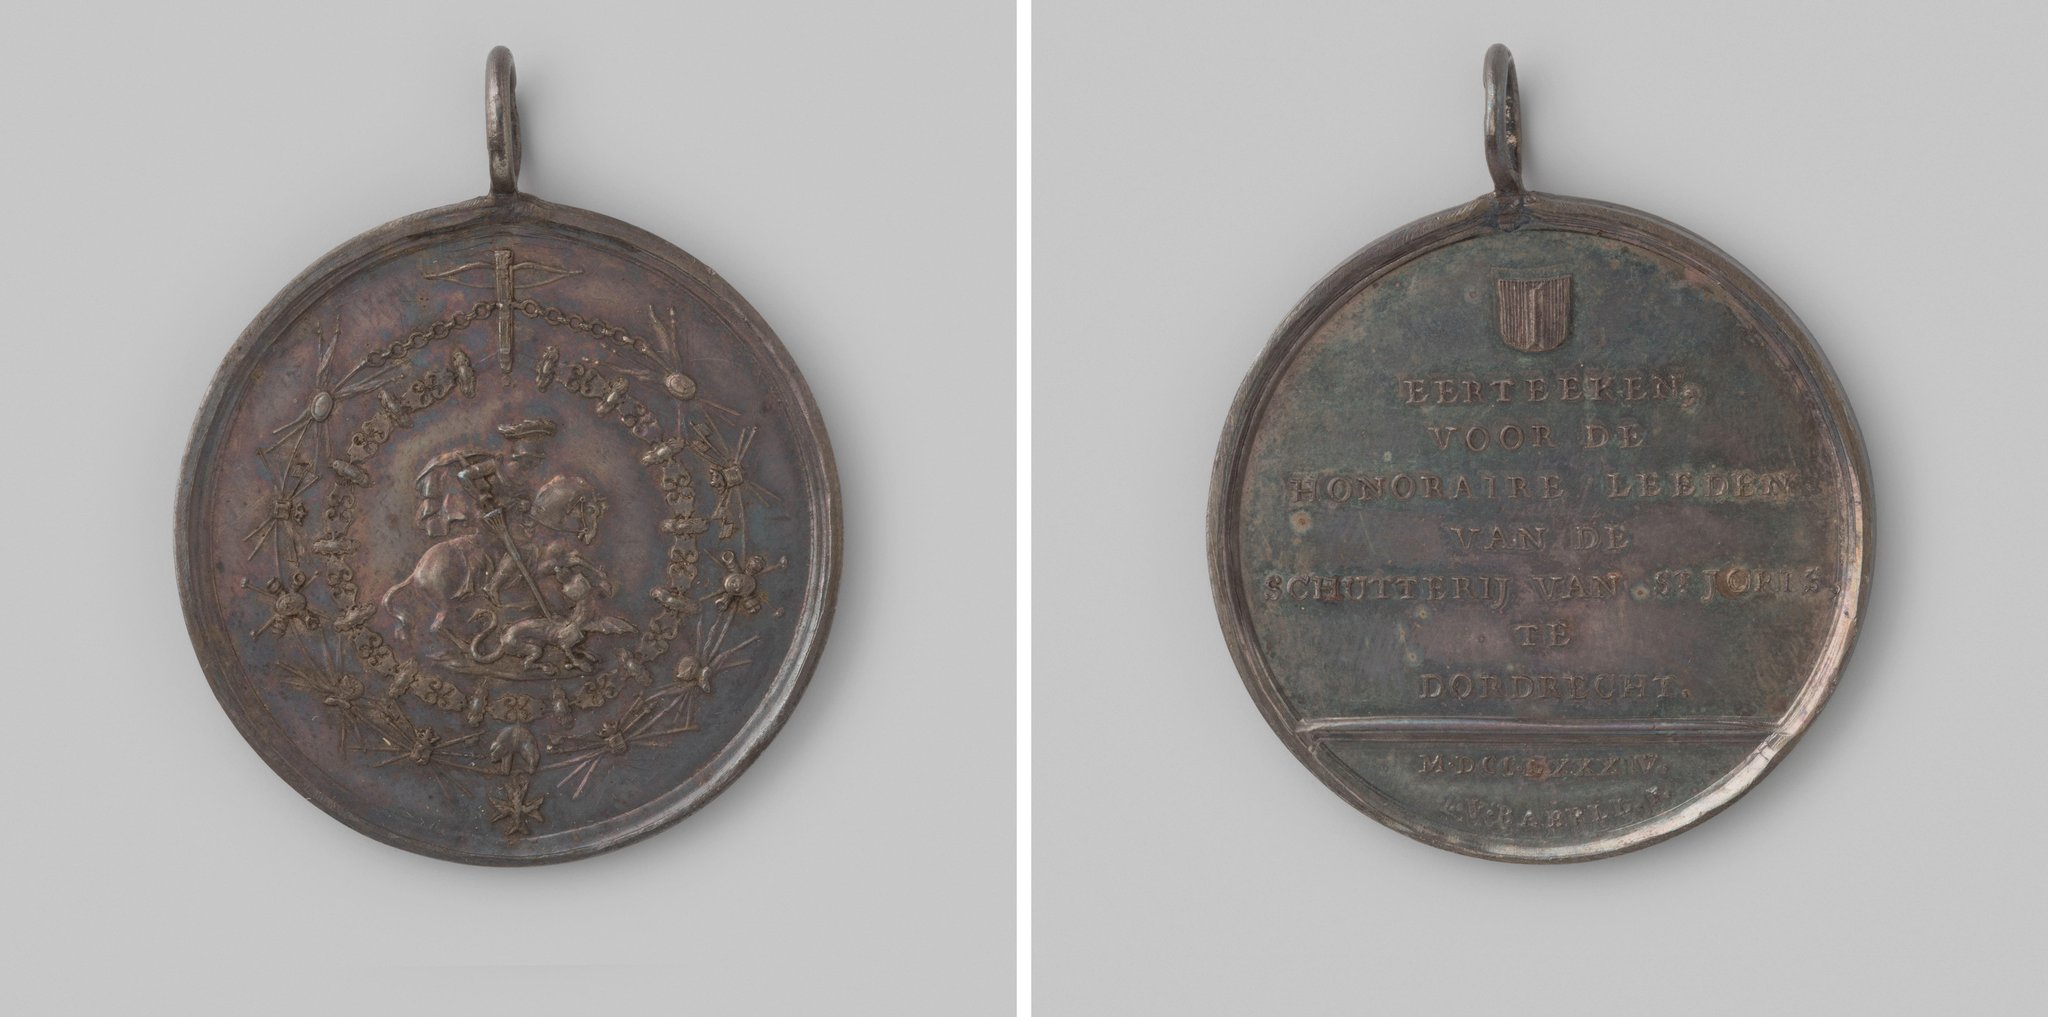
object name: honorary medal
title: Erepenning voor de honoraire leden van de Schutterij Sint Joris te Dordrecht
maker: j. van baerle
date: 1784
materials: silver